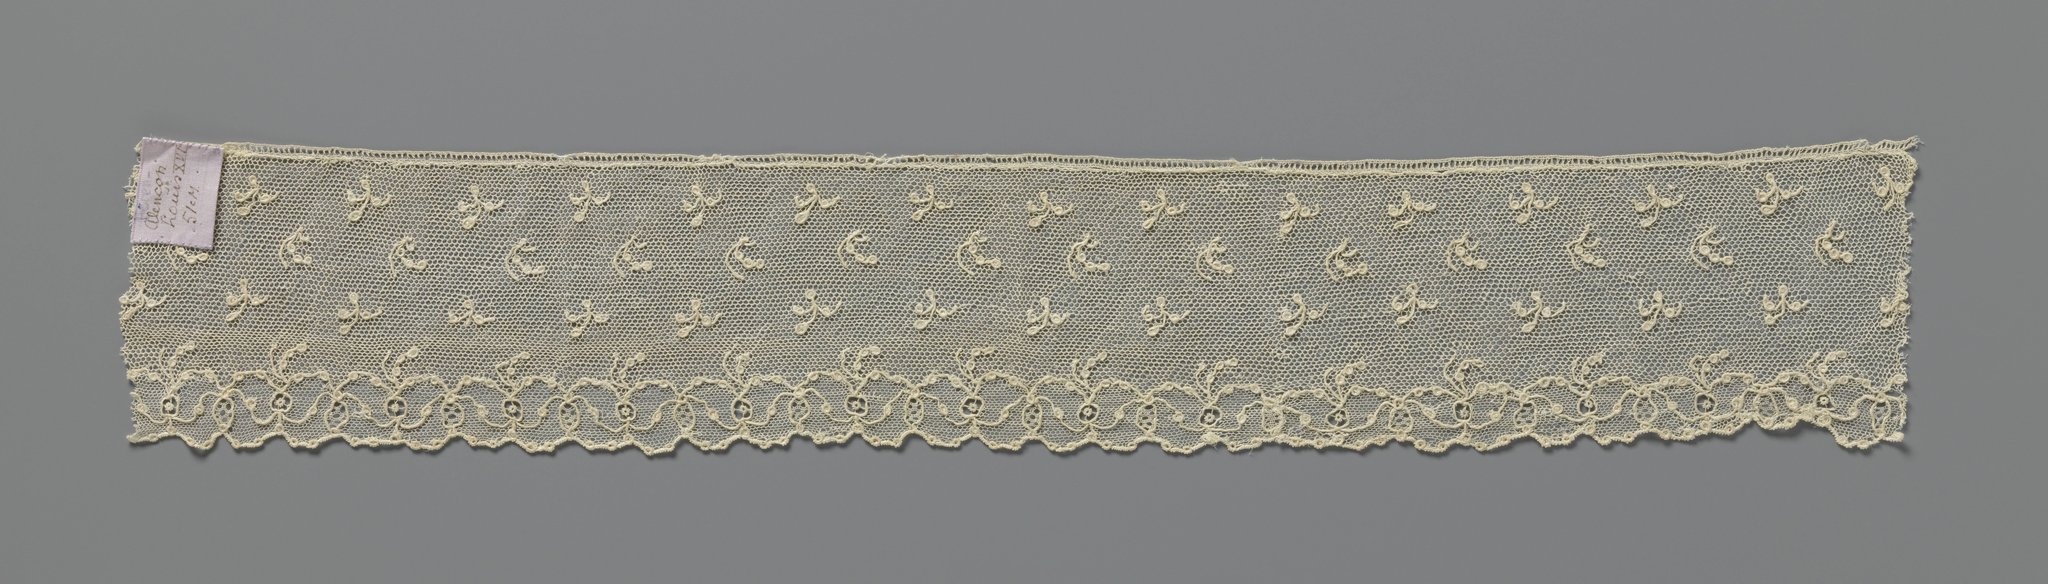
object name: strip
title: Strook naaldkant met bessentakjes strooimotief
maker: Anonymous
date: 1775-1799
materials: linen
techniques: lace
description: Strook naturelkleurige naaldkant: Alençon-kant. Strooimotief van bessentakjes op een fijne zeshoekige maasgrond. De bovenzijde is afgezet met een rand kloskant. Het patroon aan de onderkant bestaat uit cirkels, die met een nog fijnere maasgrond zijn gevuld. De cirkels overlappen elkaar deels. De ovale vormen die daardoor ontstaan zijn met afwisselend een siergronden en één raderpicot opgevuld. Gepicoteerde boogjesrand aan de onderkant.